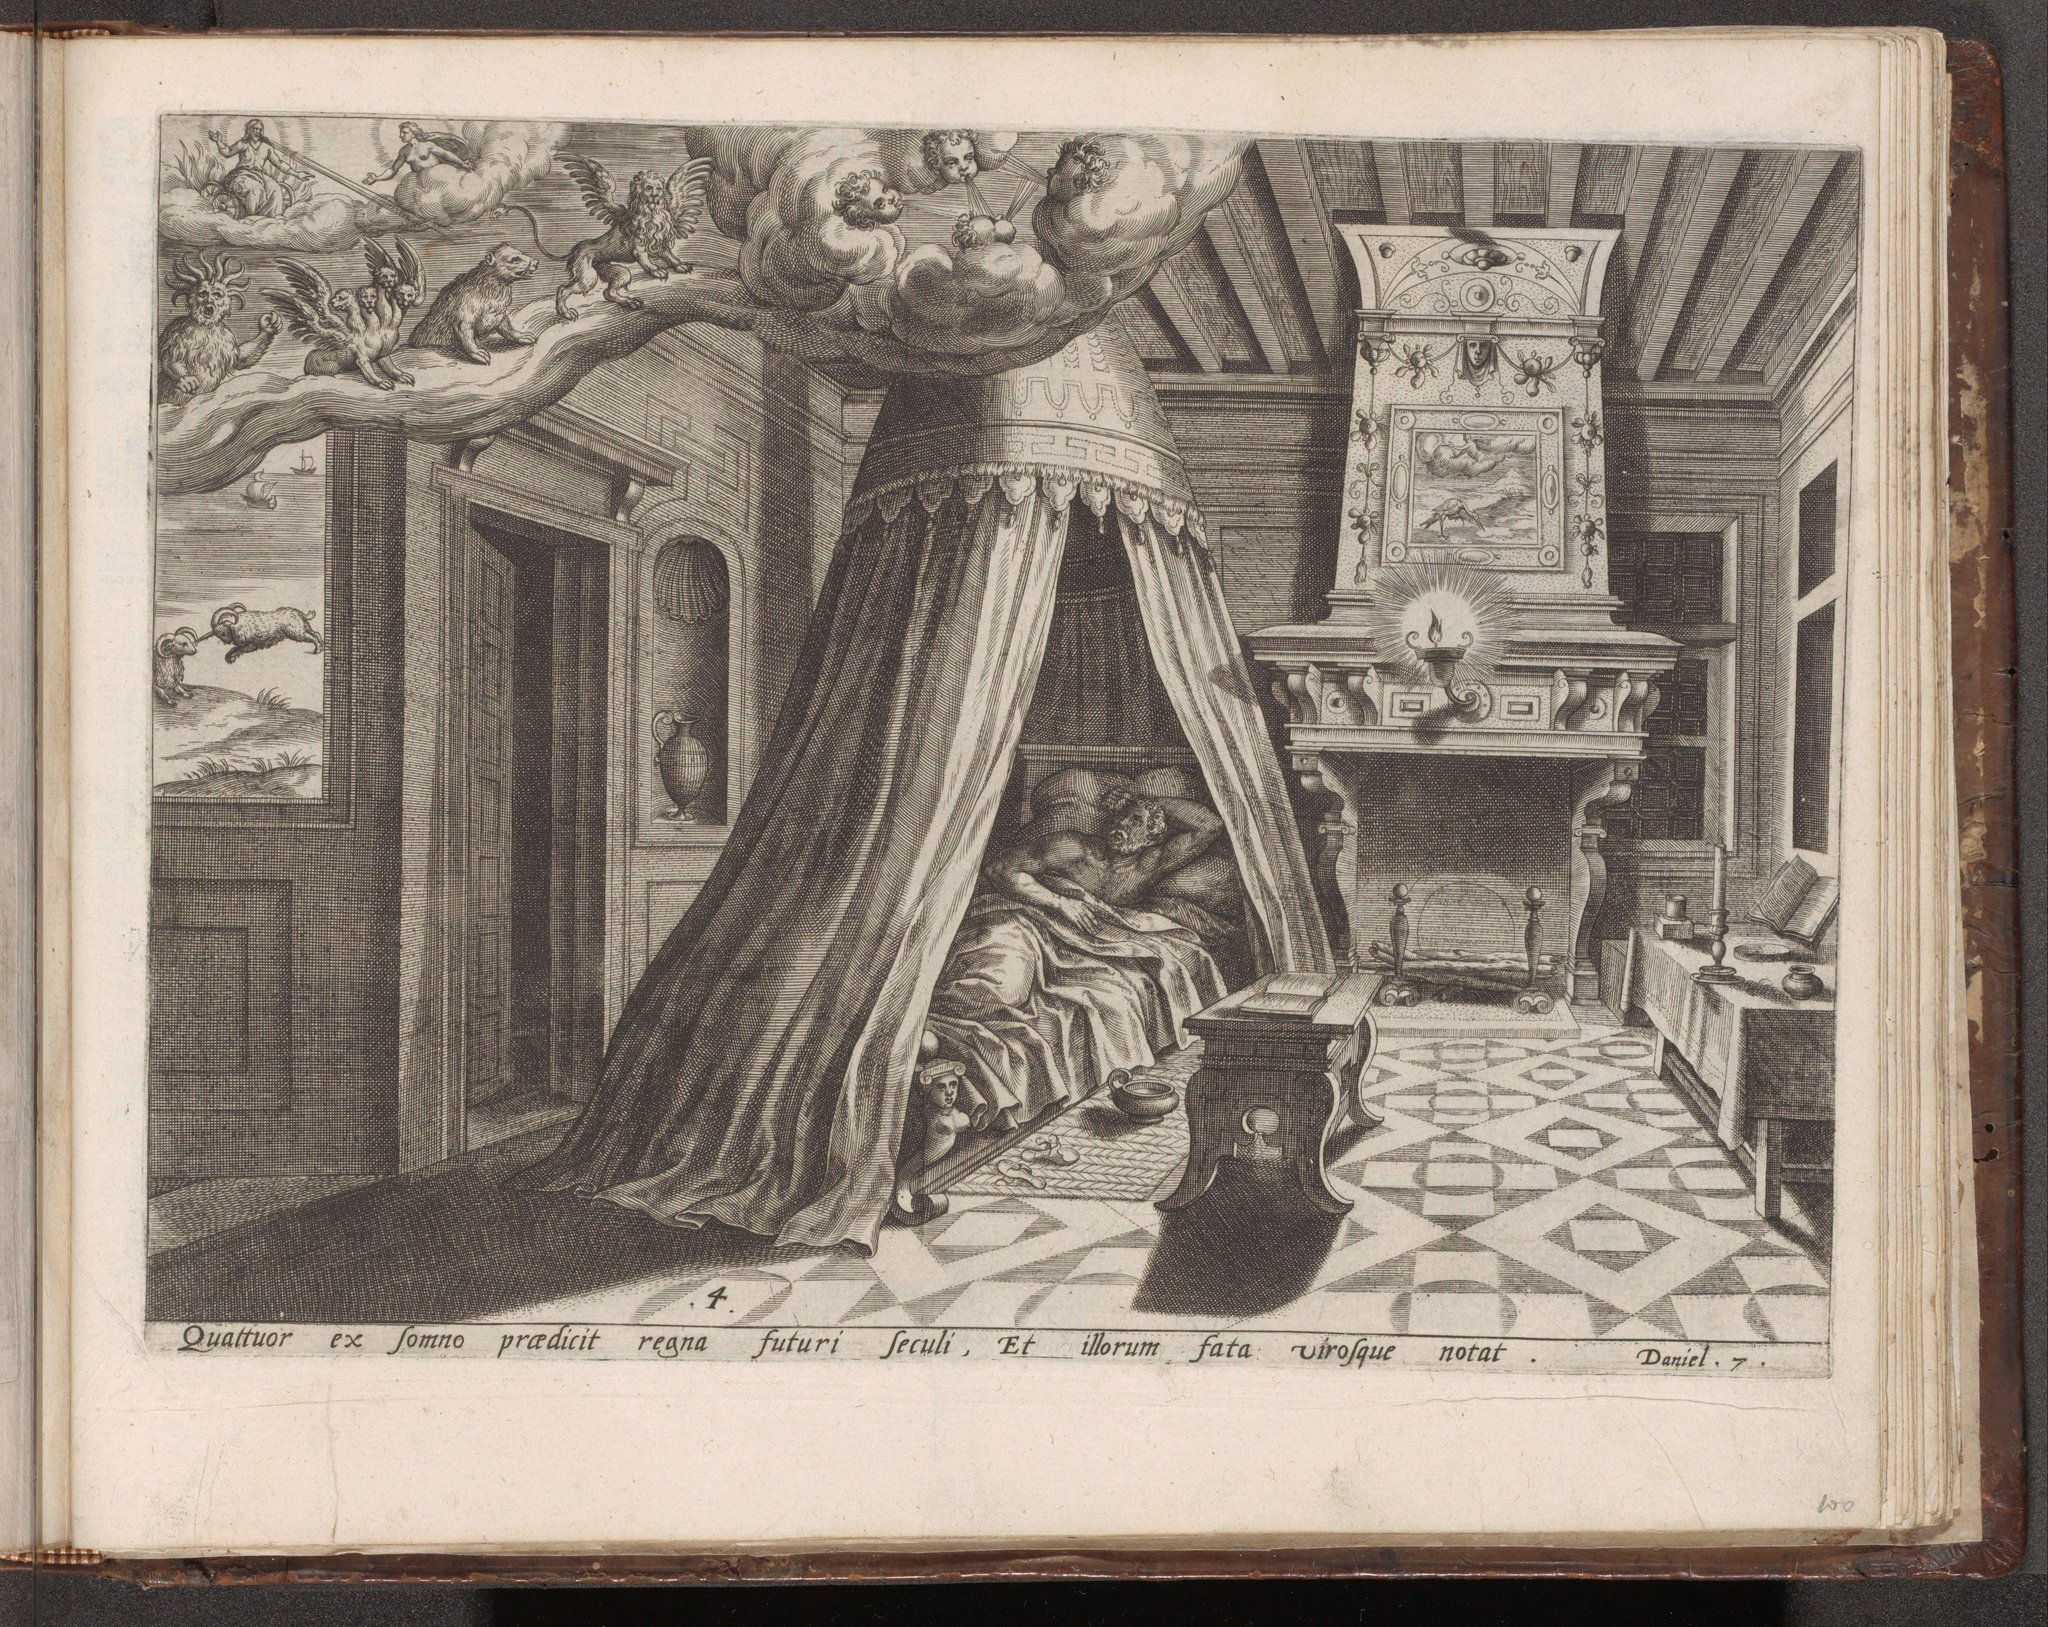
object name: album leaf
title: Daniëls droom van de vier dieren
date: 1579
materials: paper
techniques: engraving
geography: antwerp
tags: four great beasts rising from the sea ~ daniel's visions, the he-goat fights with the ram and slays it ~ daniel's visions, the ancient of days, in white robes, on a fiery throne ~ daniel's visions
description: Daniël ligt in een bed onder een baldakijn te slapen en droomt. Linksboven zijn droom van de vier dieren: een gevleugelde leeuw, een beer, een vierkoppige panter en een dier met tien horens. Daarboven de oude wijze. In het landschap links zijn visioen van de ram en de geitenbok. Onder de voorstelling een verwijzing in het Latijn naar de Bijbeltekst in Dan. 7. Prent maakt deel uit van een album.